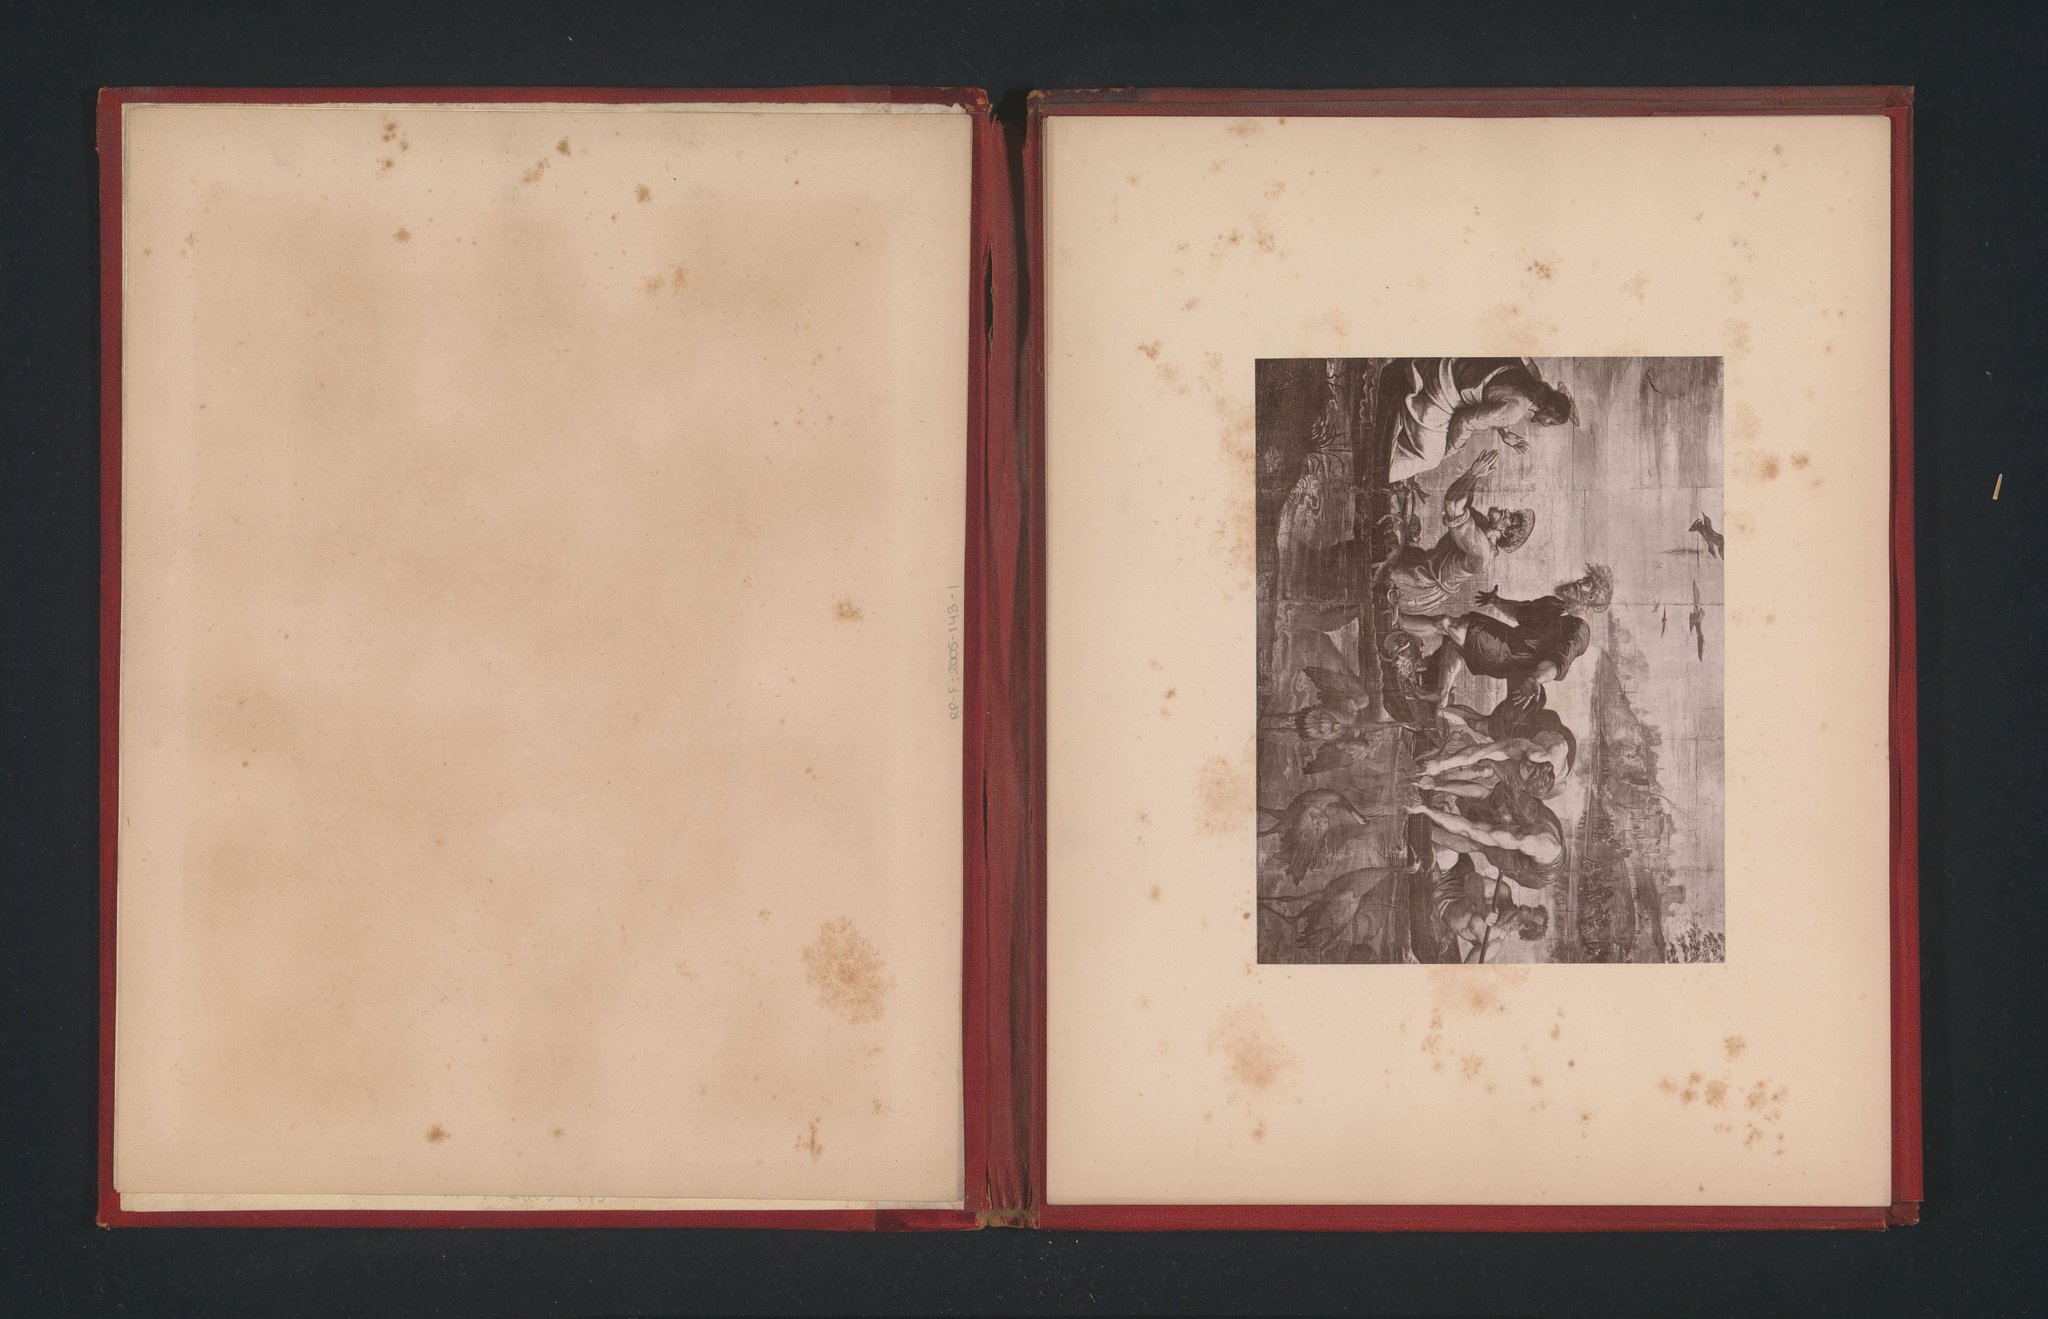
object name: photomechanical print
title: Miraculous Draught of Fishes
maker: charles thurston thompson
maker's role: fotograaf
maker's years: 1816-1868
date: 1880-1885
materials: paper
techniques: woodburytype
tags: the miraculous draught of fishes (before the resurrection) on the lake of gennesaret (sea of galilee); james and john helping to bring in the nets (luke 5:1-11)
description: Deze prent maakt deel uit van omslag met 9 bladen.